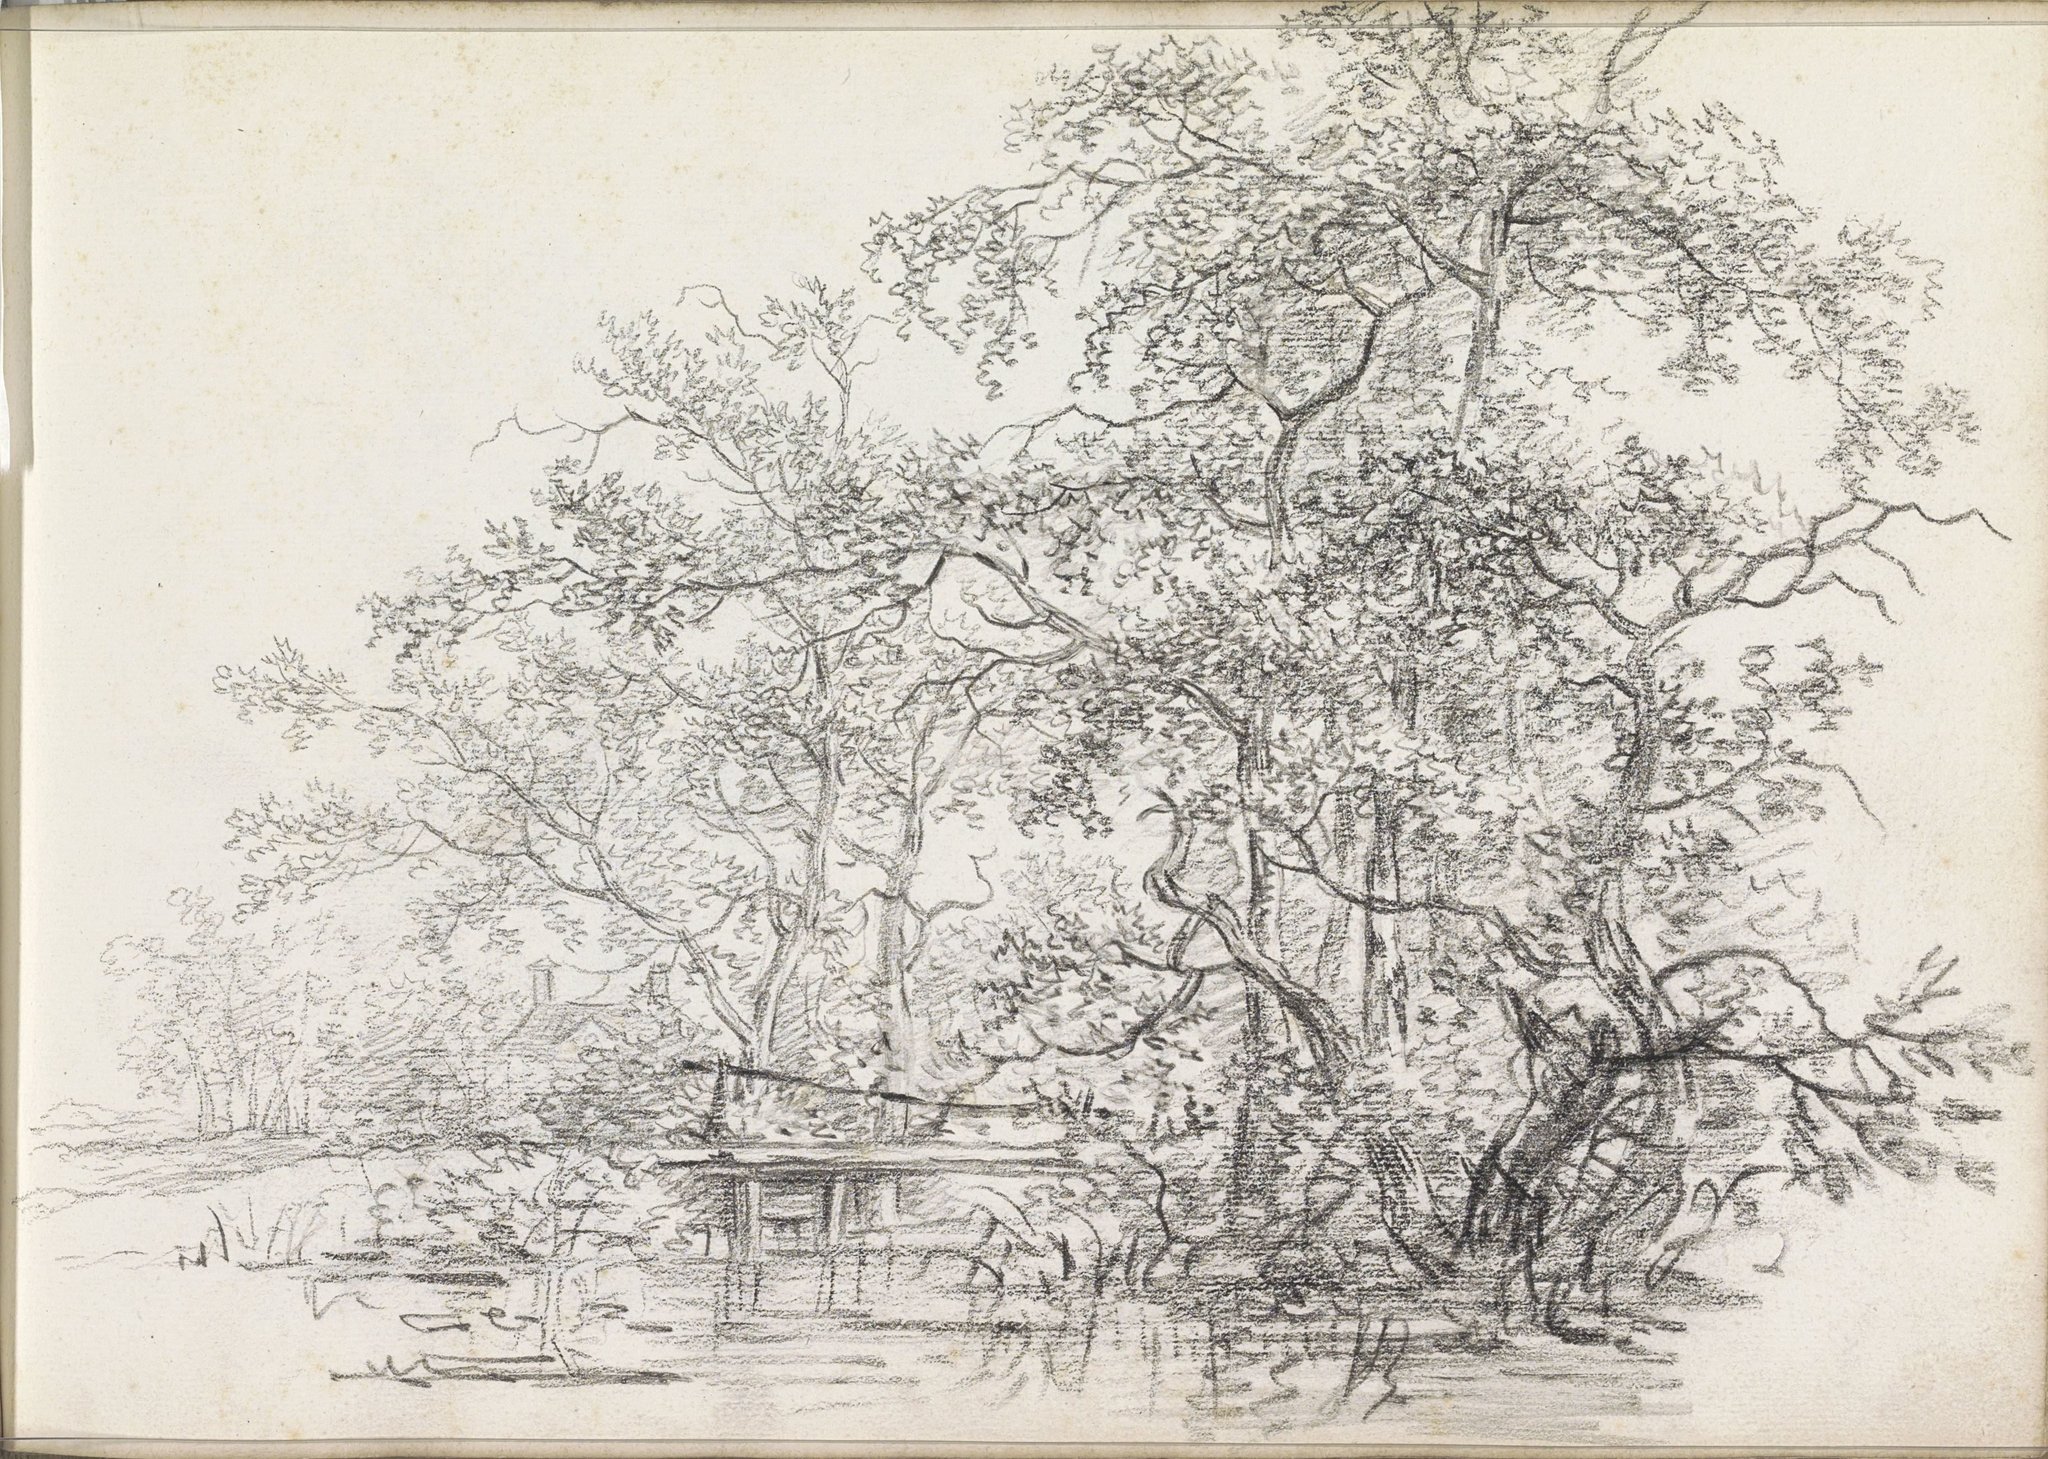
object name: sketchbook leaf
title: Brug over water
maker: andreas schelfhout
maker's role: draughtsman, painter, print maker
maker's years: 1787-1870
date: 1811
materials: chalk, paper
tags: trees, bridge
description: Langs de waterkant staan bomen. Op de achtergrond een plattelandswoning. Blad 30 recto uit een schetsboek met 75 bladen.